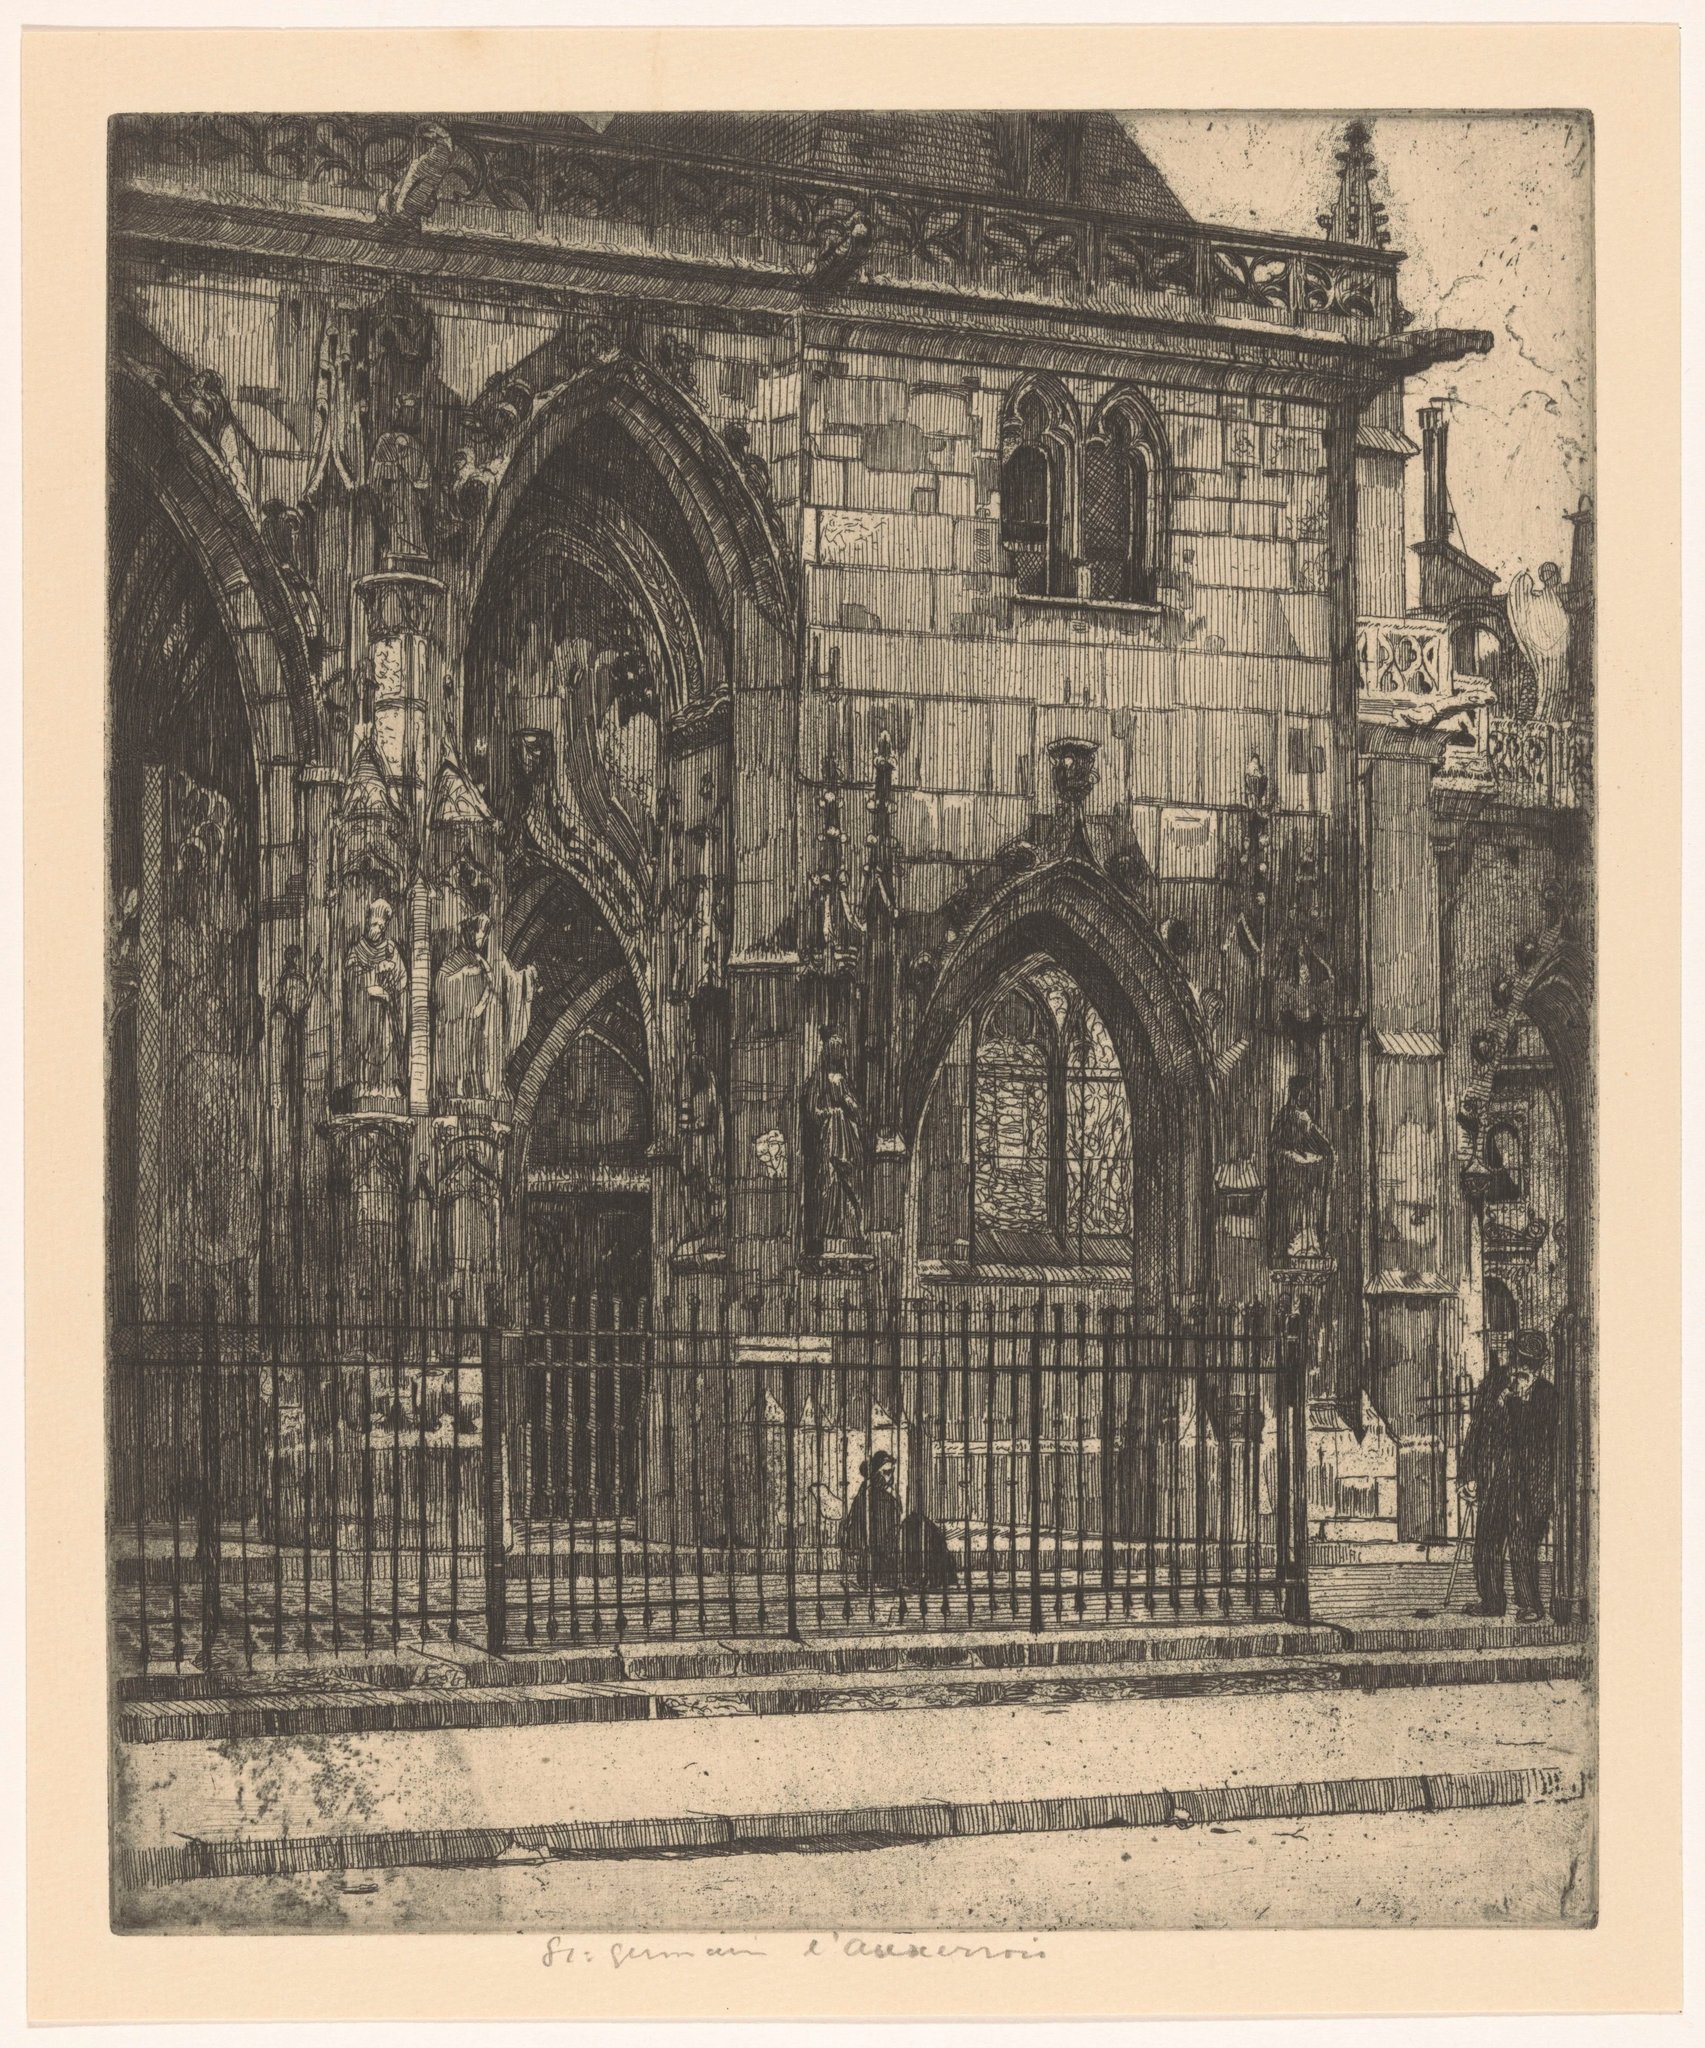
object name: print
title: Gevel van de Saint-Germain-l'Auxerrois in Parijs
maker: martin monnickendam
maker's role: draughtsman, painter, print maker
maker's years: 1874-1943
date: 1896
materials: paper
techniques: etching, intaglio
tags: fence, wall, paling, church (exterior), paris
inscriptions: collector's mark: Lugt 2228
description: Voor de kerk staat een metalen hek. Rechts bij het hek staat een man met een hoed en een wandelstok.